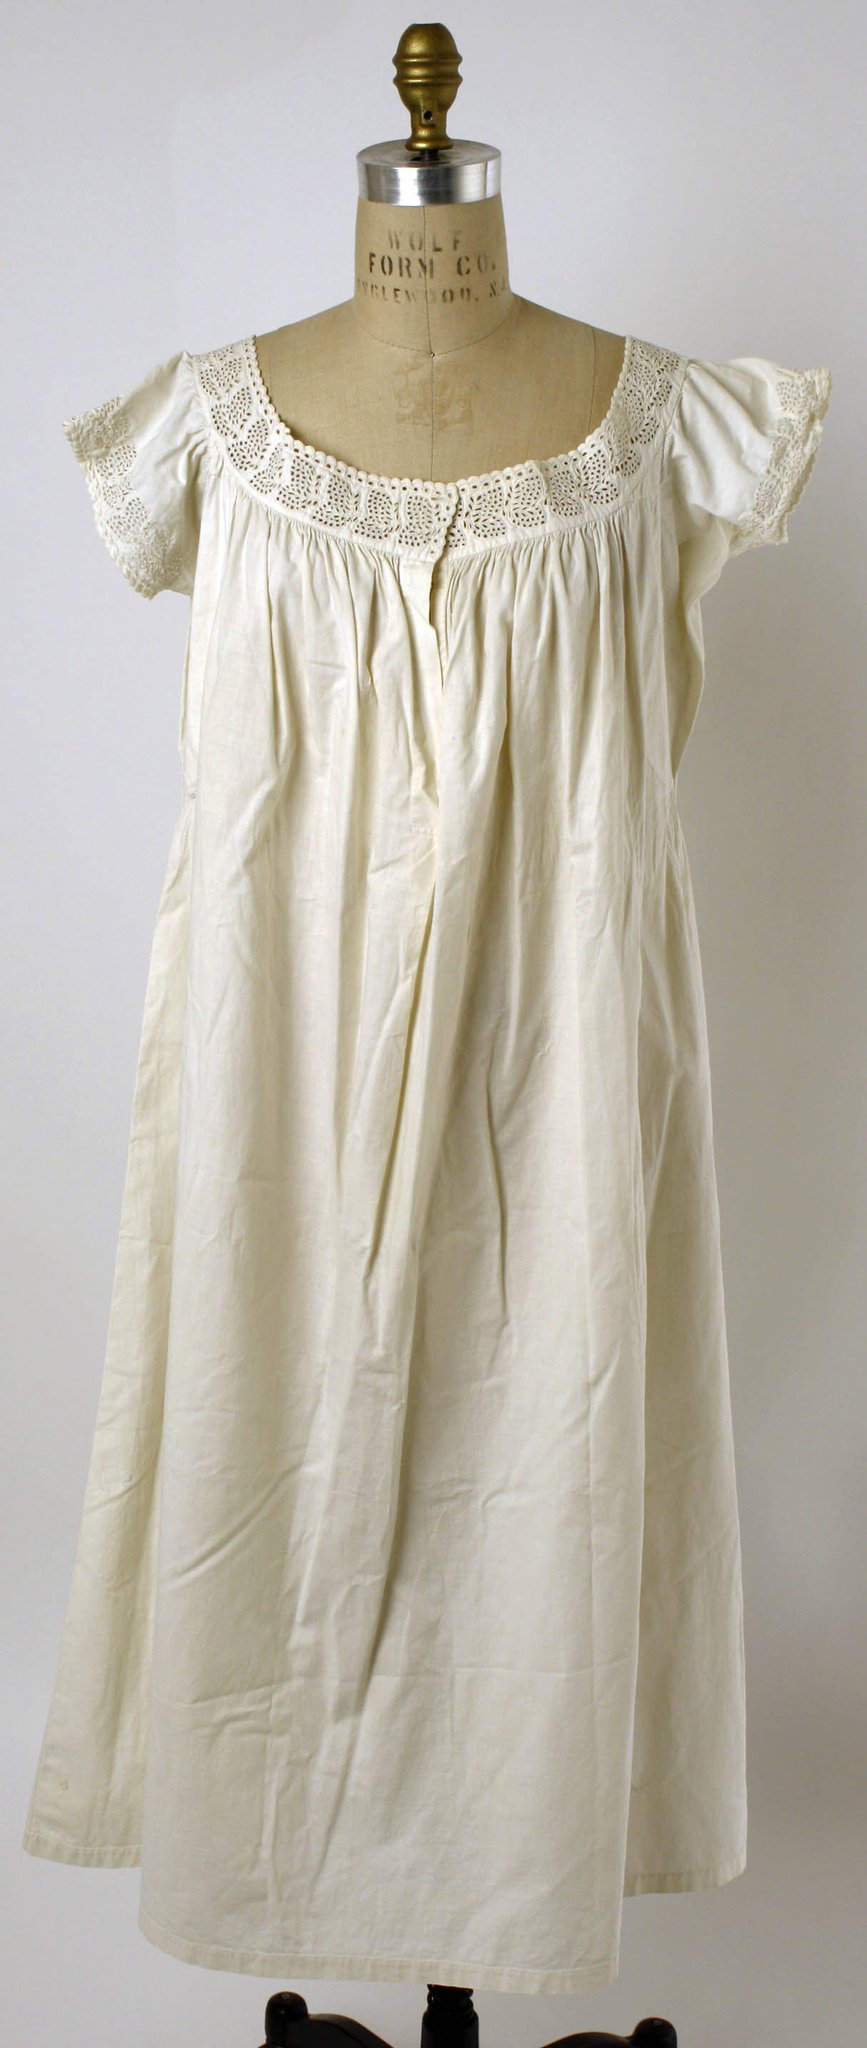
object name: chemise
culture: american or european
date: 1861-1865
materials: linen